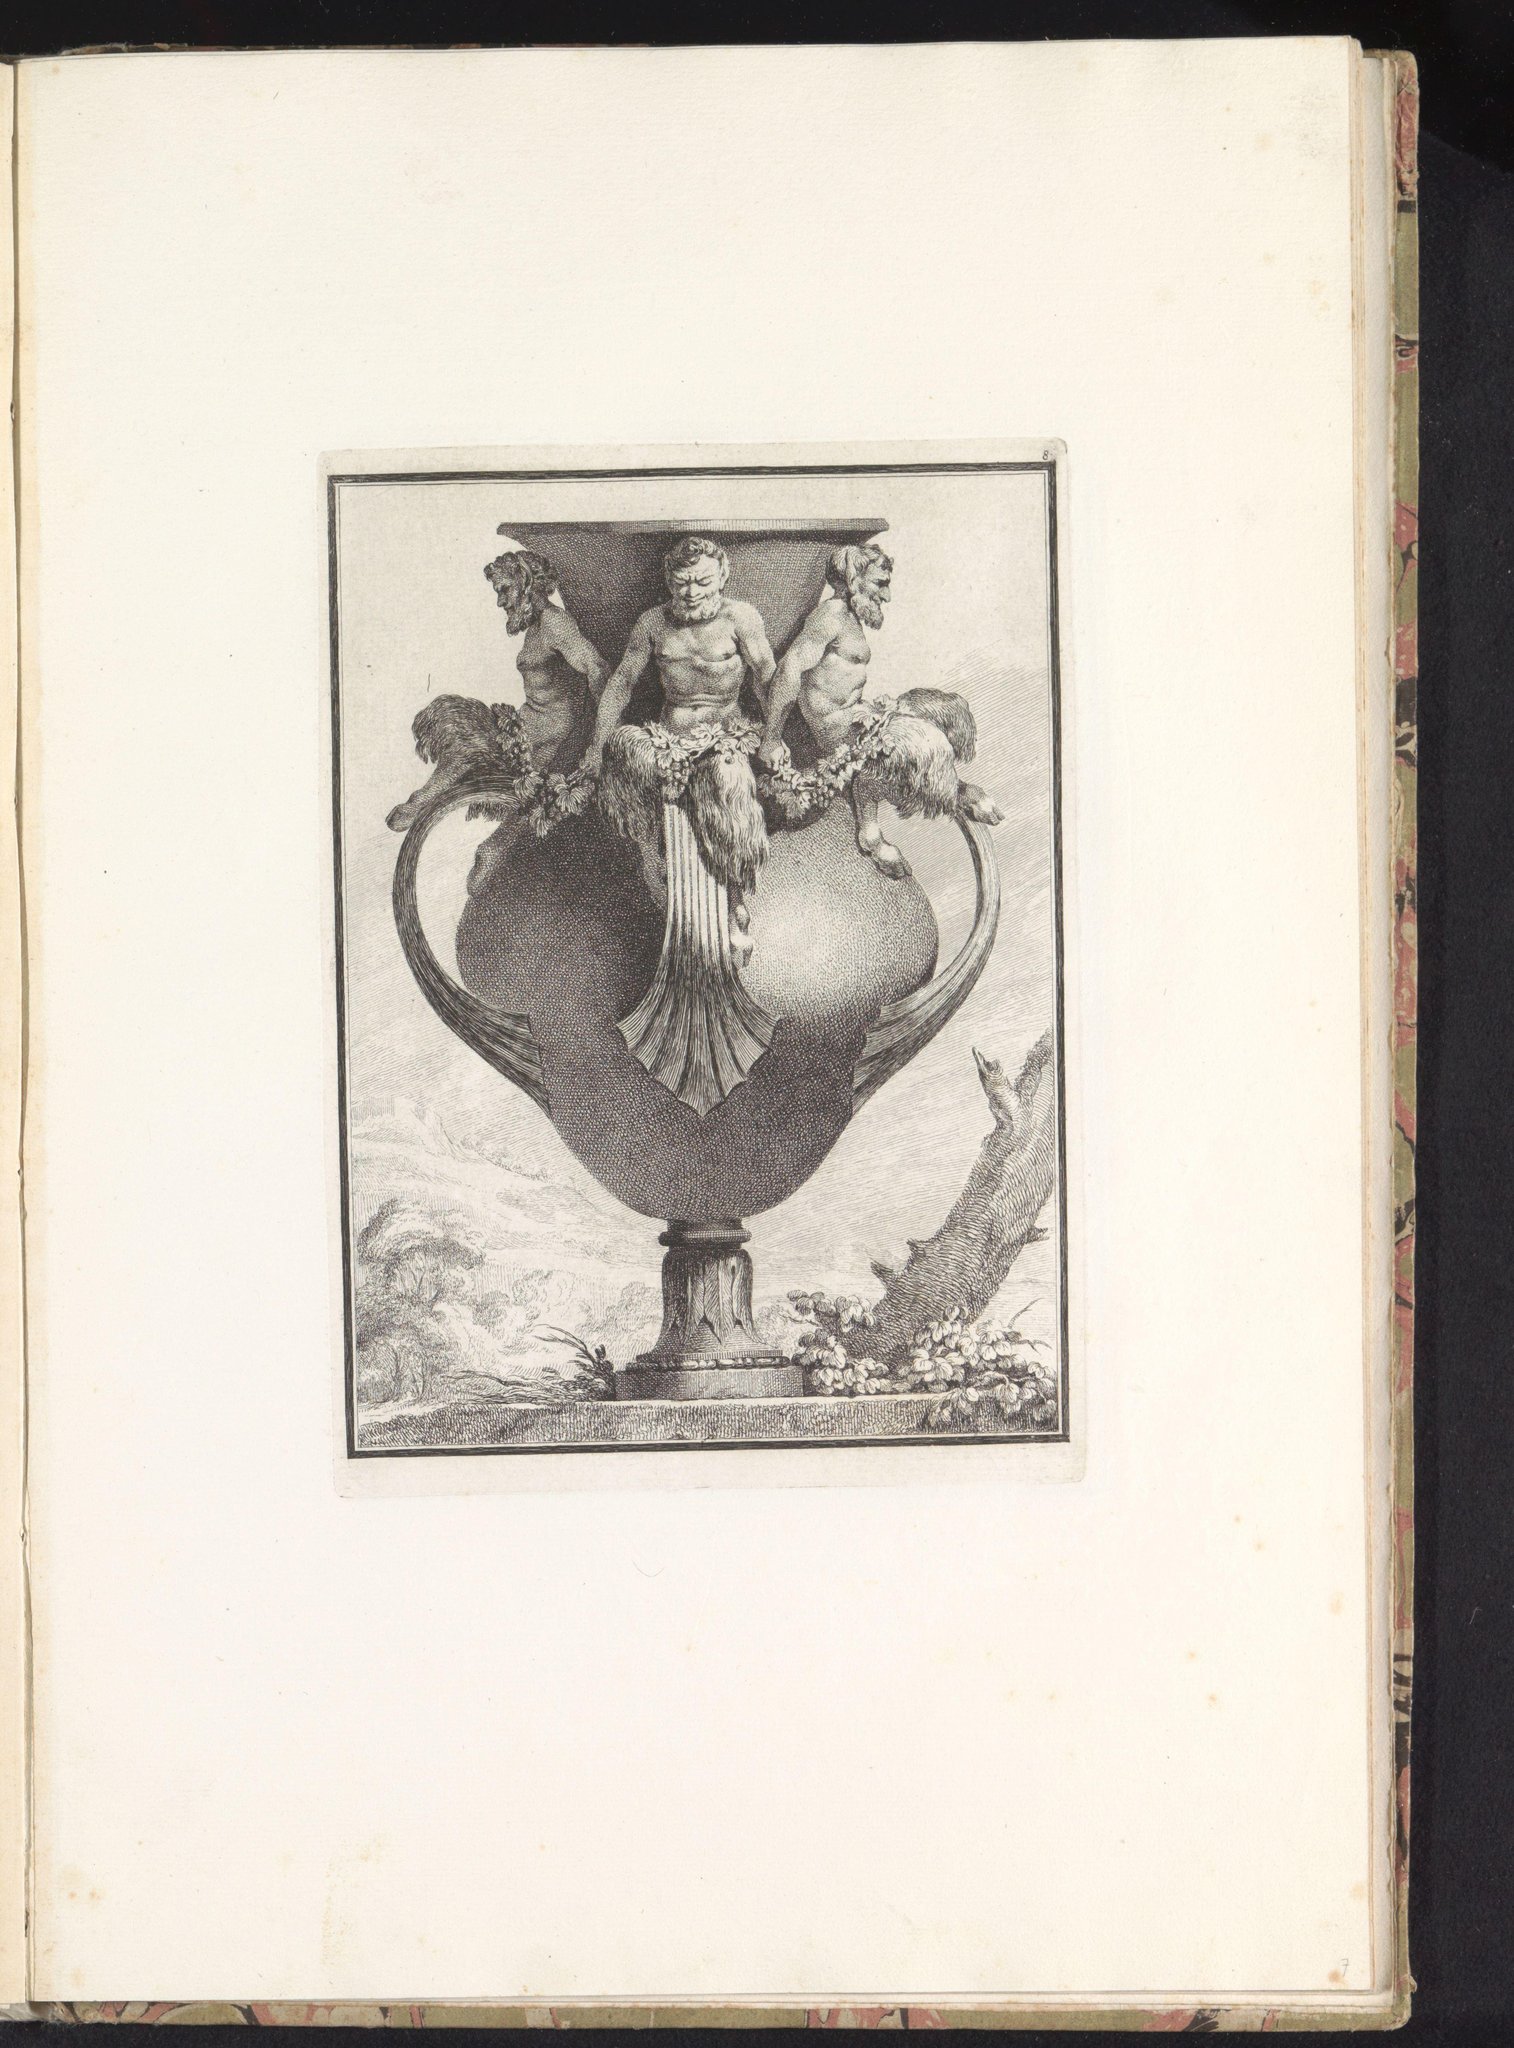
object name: album leaf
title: Ornamentele vazen uit de collectie van Guillaume du Tillot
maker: benigno bossi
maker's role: print maker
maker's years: 1727-1792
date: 1764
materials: paper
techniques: etching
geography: parma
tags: vase ~ ornament, satyr(s) (in general)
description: Grote vaas, staande op een muur met landschap op de achtergrond. De vaas heeft vier oren, waarvan er drie zichtbaar zijn. Op de oren zitten saters. No. 8 uit serie van 31. Prent maakt deel uit van een album. Gedrukt recto rechtsboven: 8.